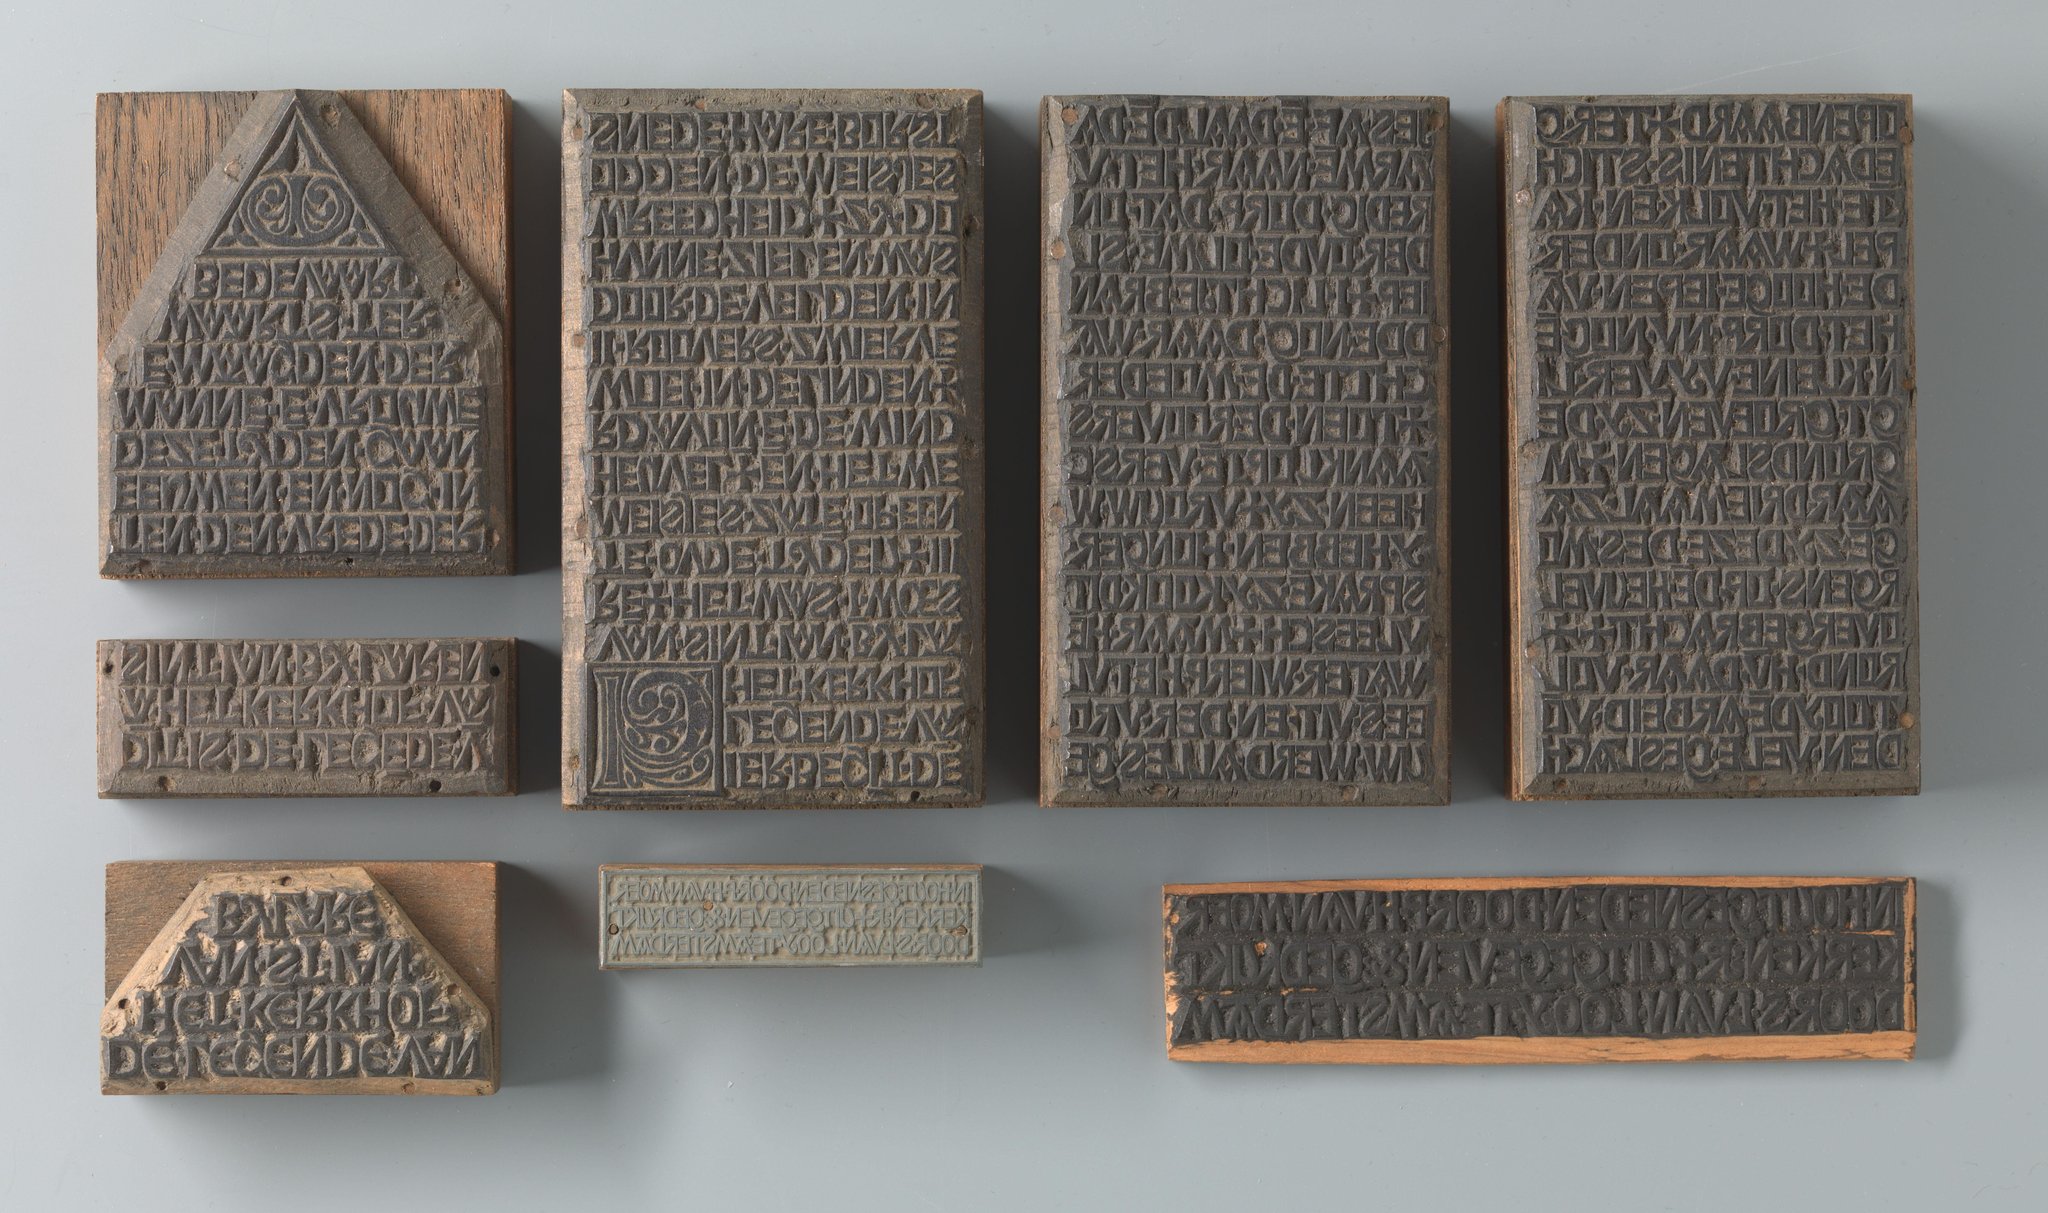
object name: wood block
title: Legende van het kerkhof van St.-Jan bij Laren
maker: pieter hendrik van moerkerken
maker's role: print maker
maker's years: 1877-1951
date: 1899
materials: wood, zinc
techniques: printing block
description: Kist met acht houtblokken en een zinkplaat.